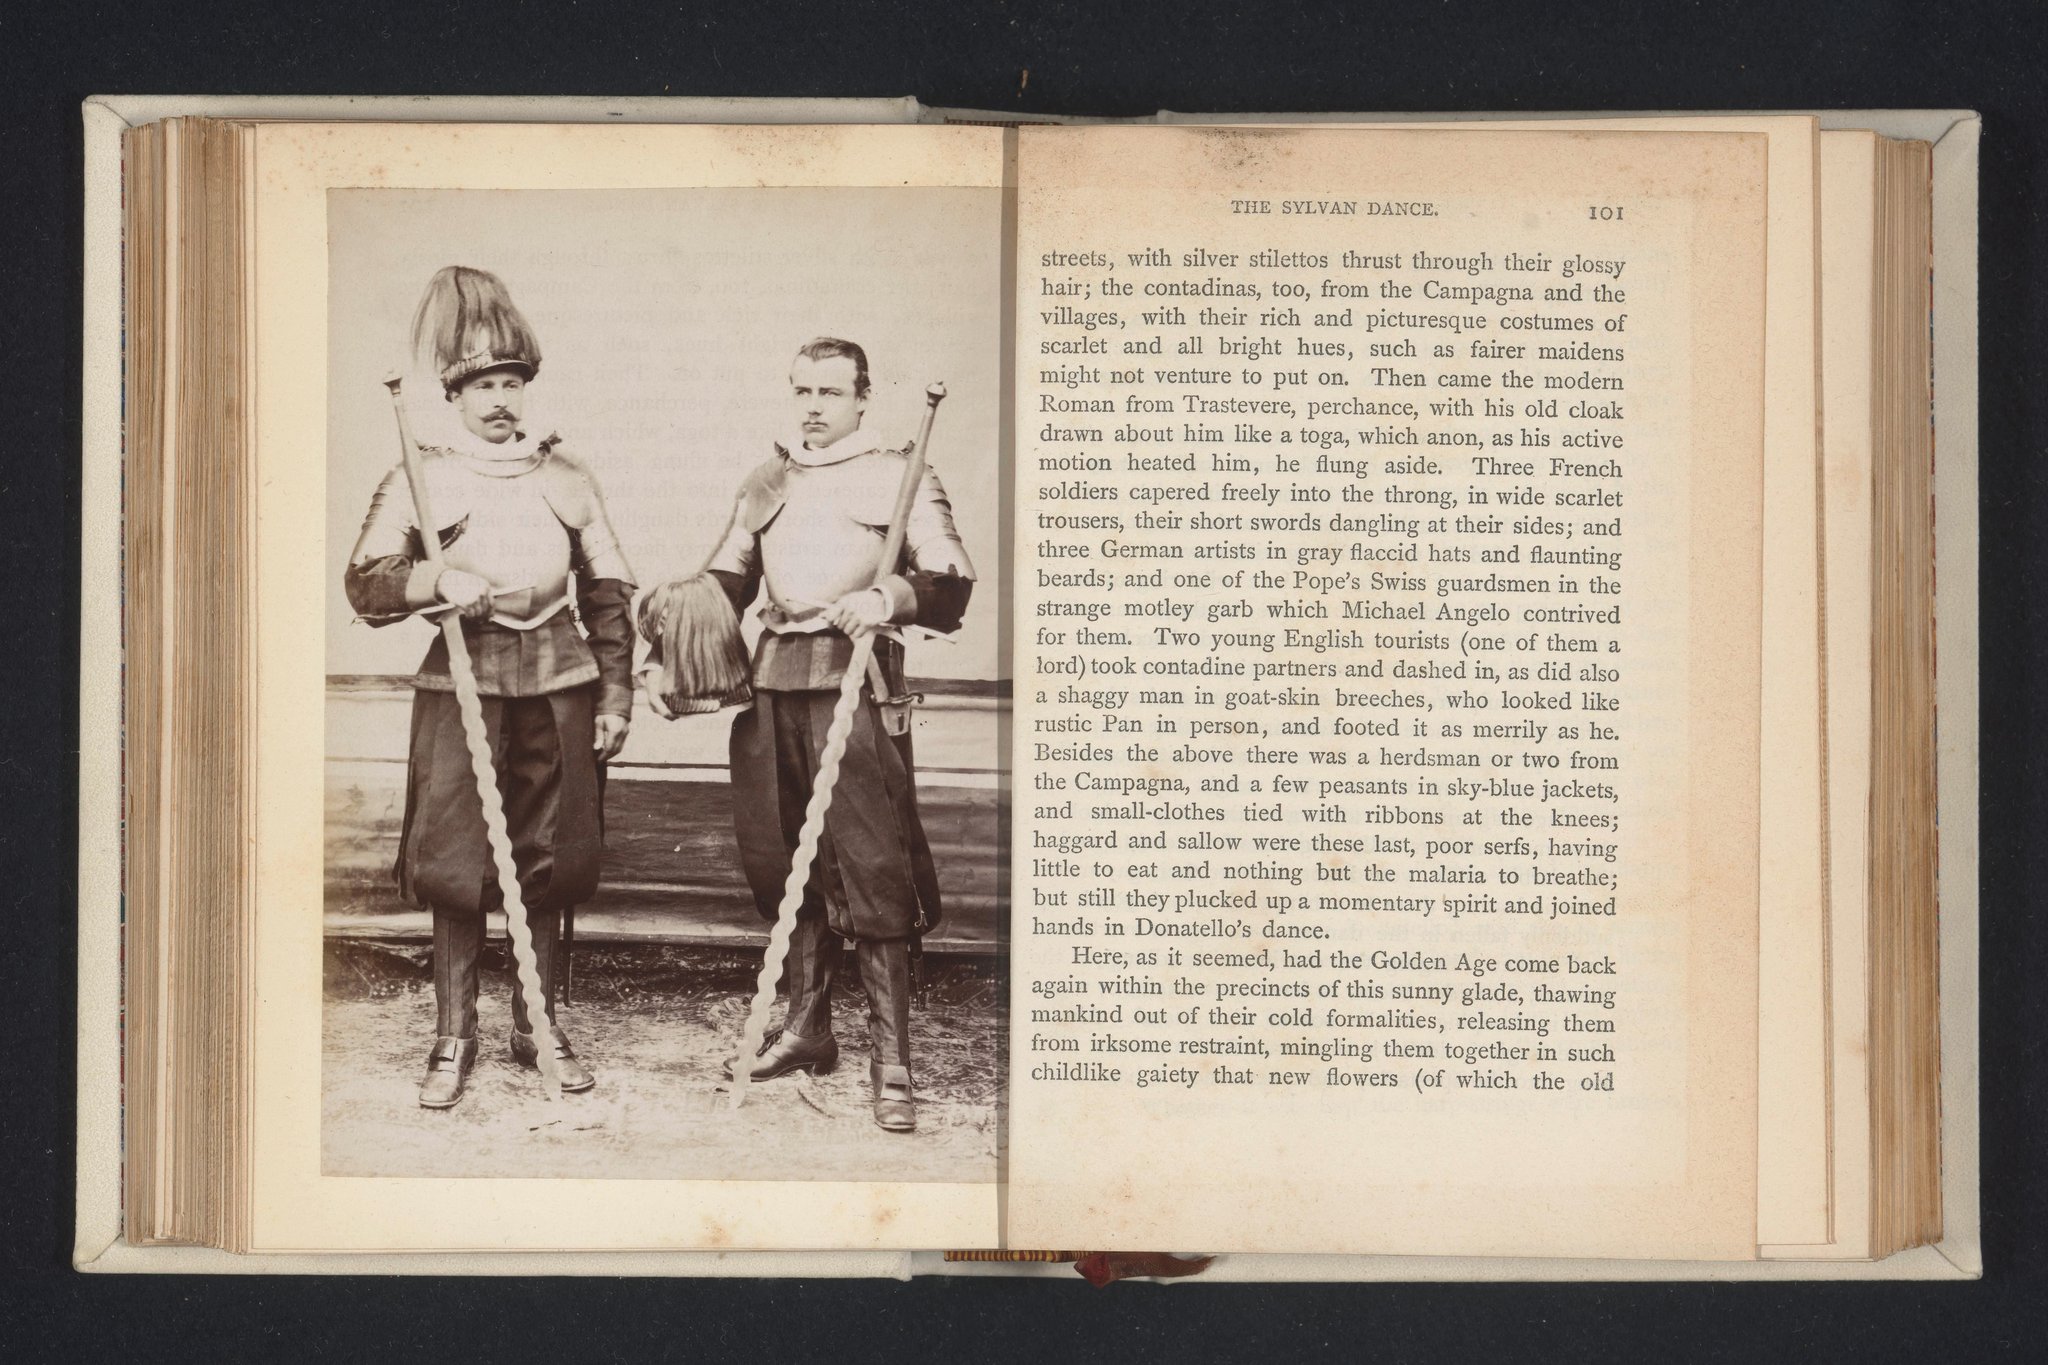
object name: photograph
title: Portret van twee onbekende soldaten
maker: Anonymous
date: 1850-1860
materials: photographic support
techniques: albumen print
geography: italy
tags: the soldier; the soldier's life, historical persons not known by name